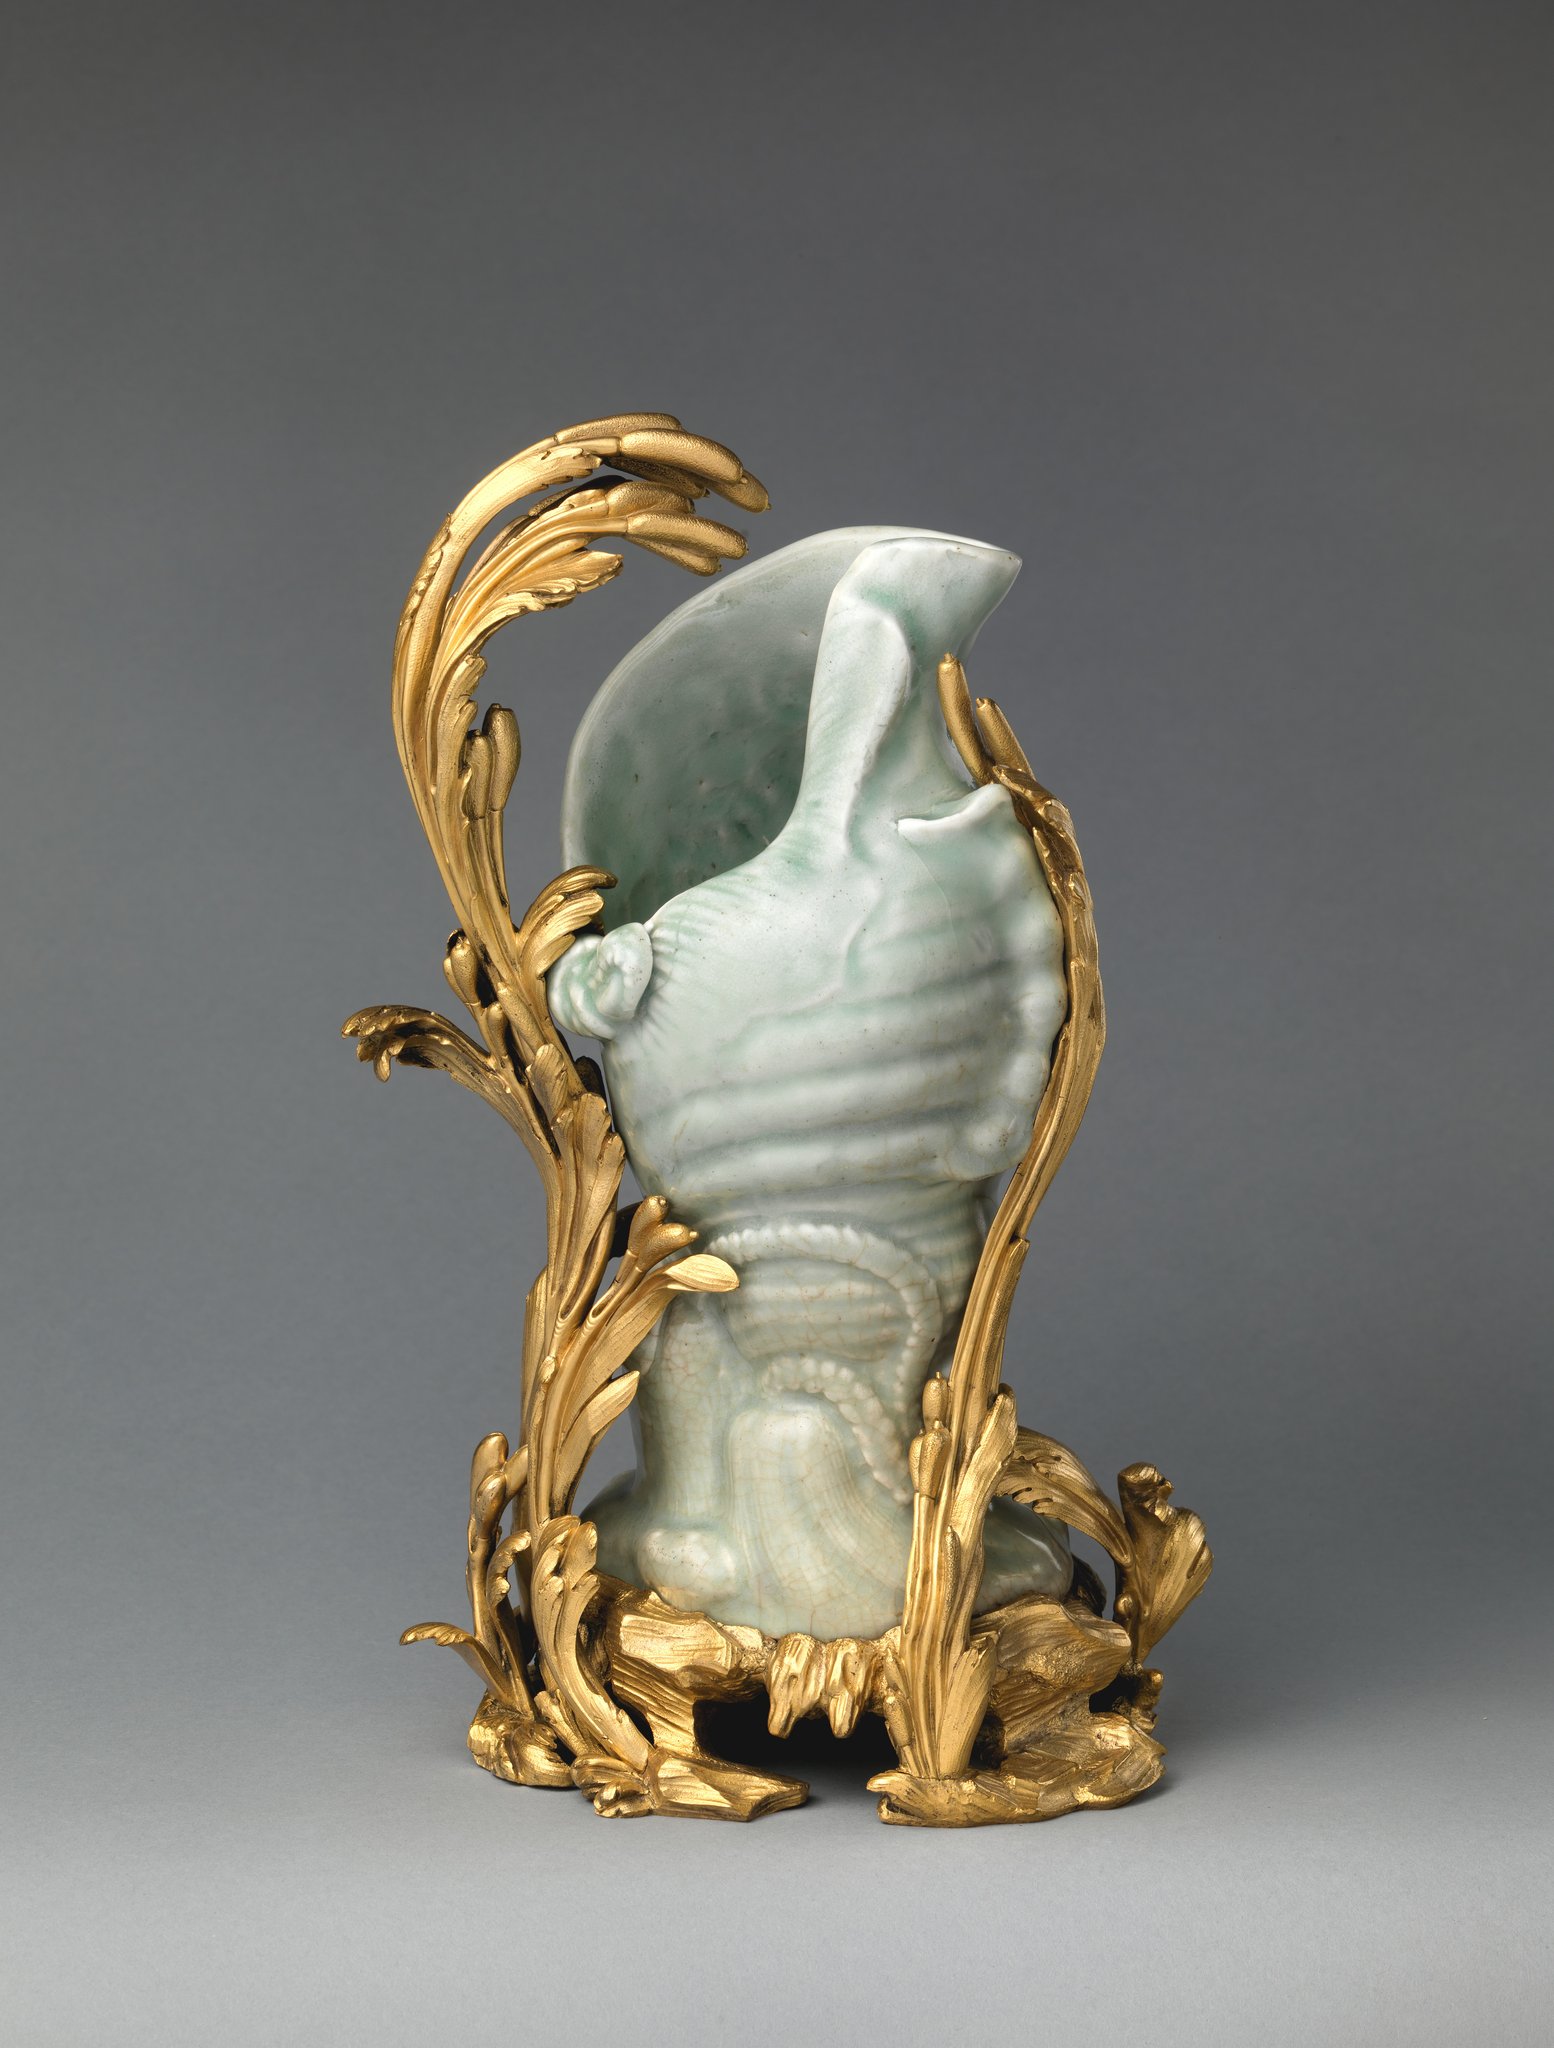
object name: mounted ewer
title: Ewer in the form of a conch shell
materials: gilt bronze, hard paste porcelain